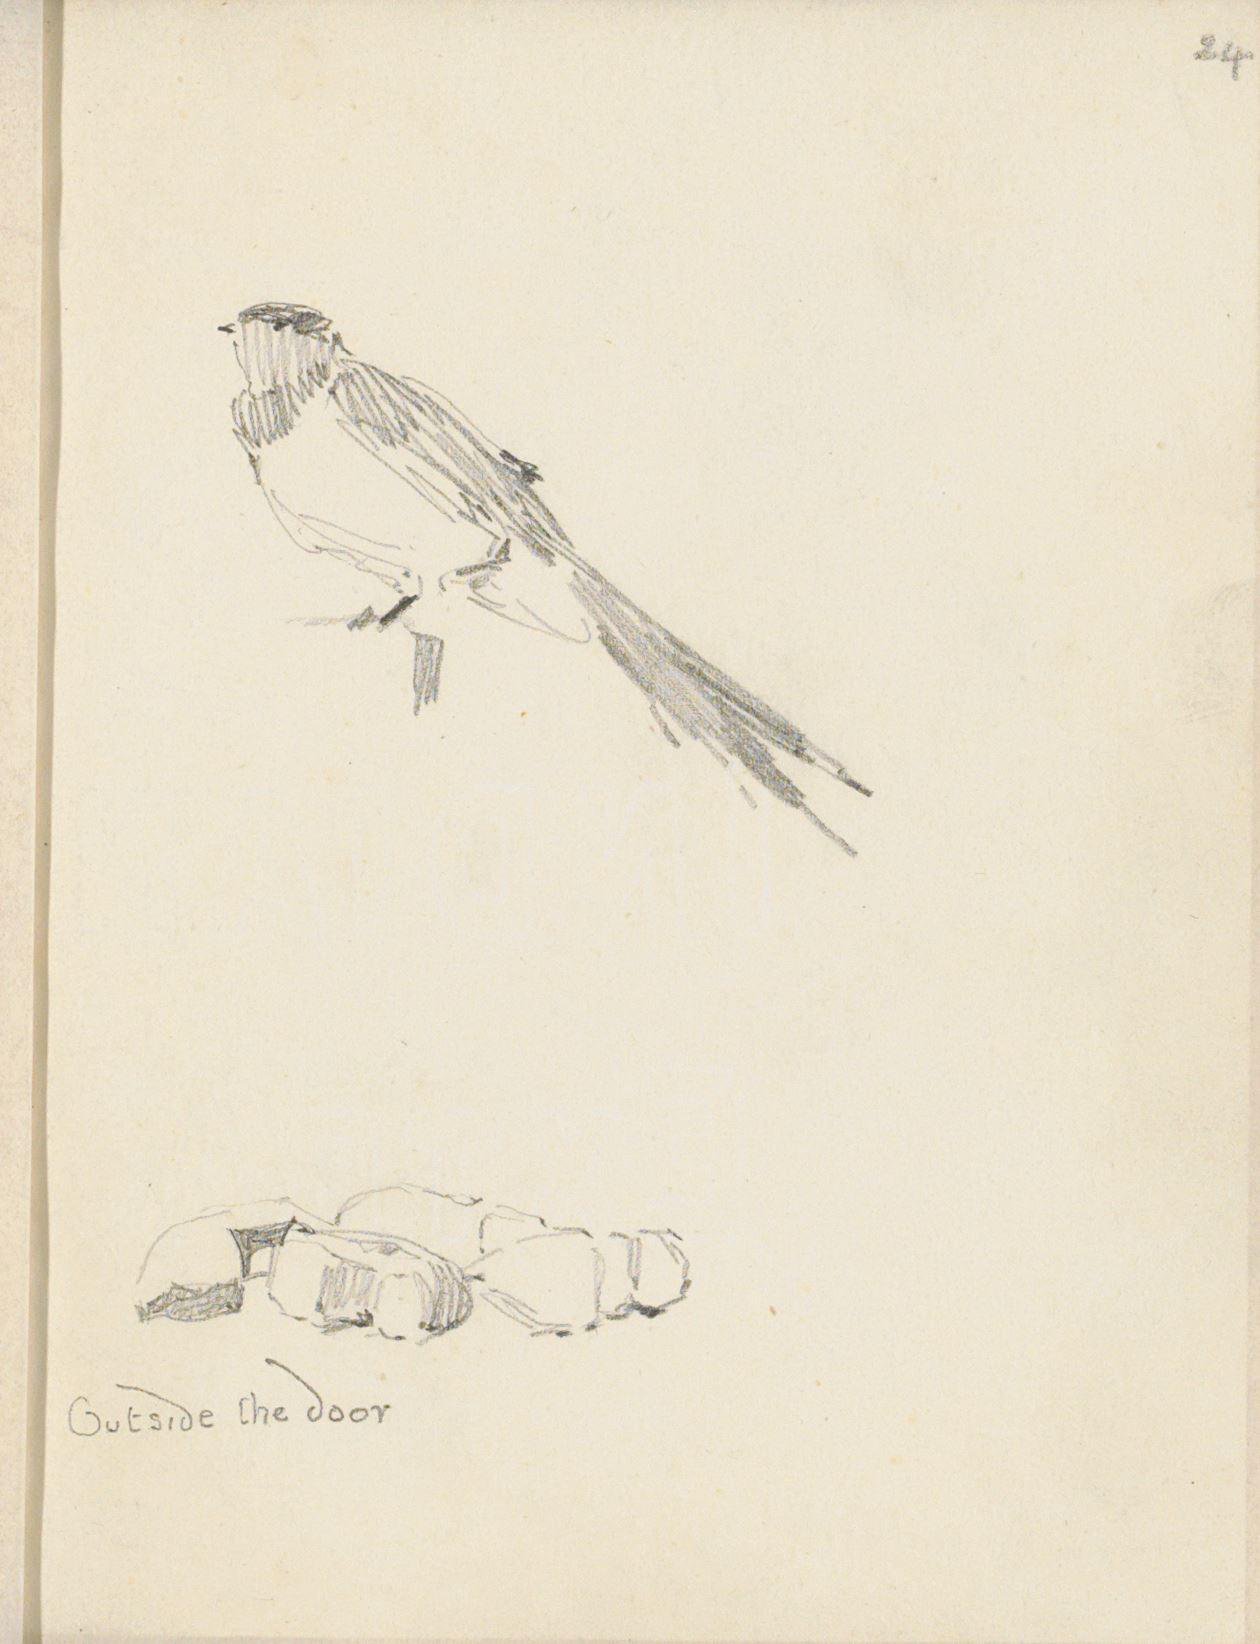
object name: sketchbook leaf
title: Stenen en een vogel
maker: alfred william rich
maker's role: draughtsman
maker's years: 1856-1921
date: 1892-1893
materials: paper, pencil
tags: birds, boulder, stone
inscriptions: annotation: ‘Outside the door’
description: Blad 24 recto uit een schetsboek met 86 bladen.